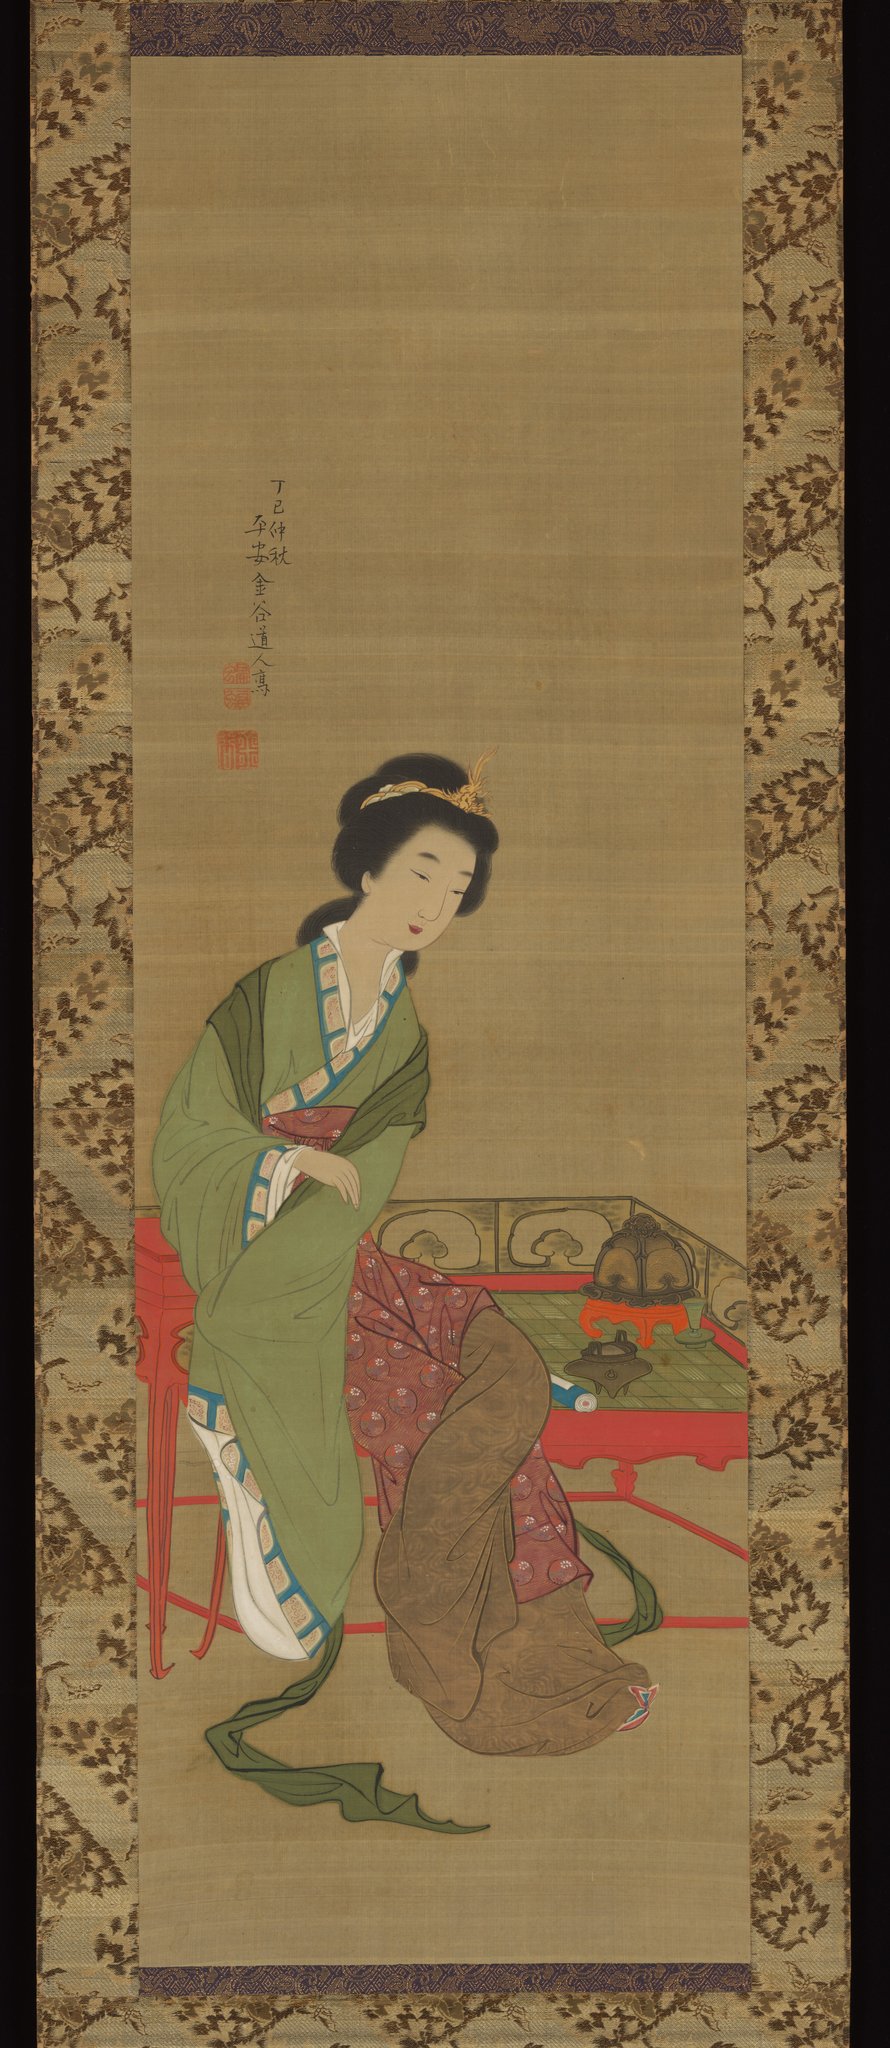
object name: hanging scroll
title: Chinese Beauty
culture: japanese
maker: yokoi kinkoku 横井金谷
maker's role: artist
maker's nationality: japanese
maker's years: 1761-1832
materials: ink, silk